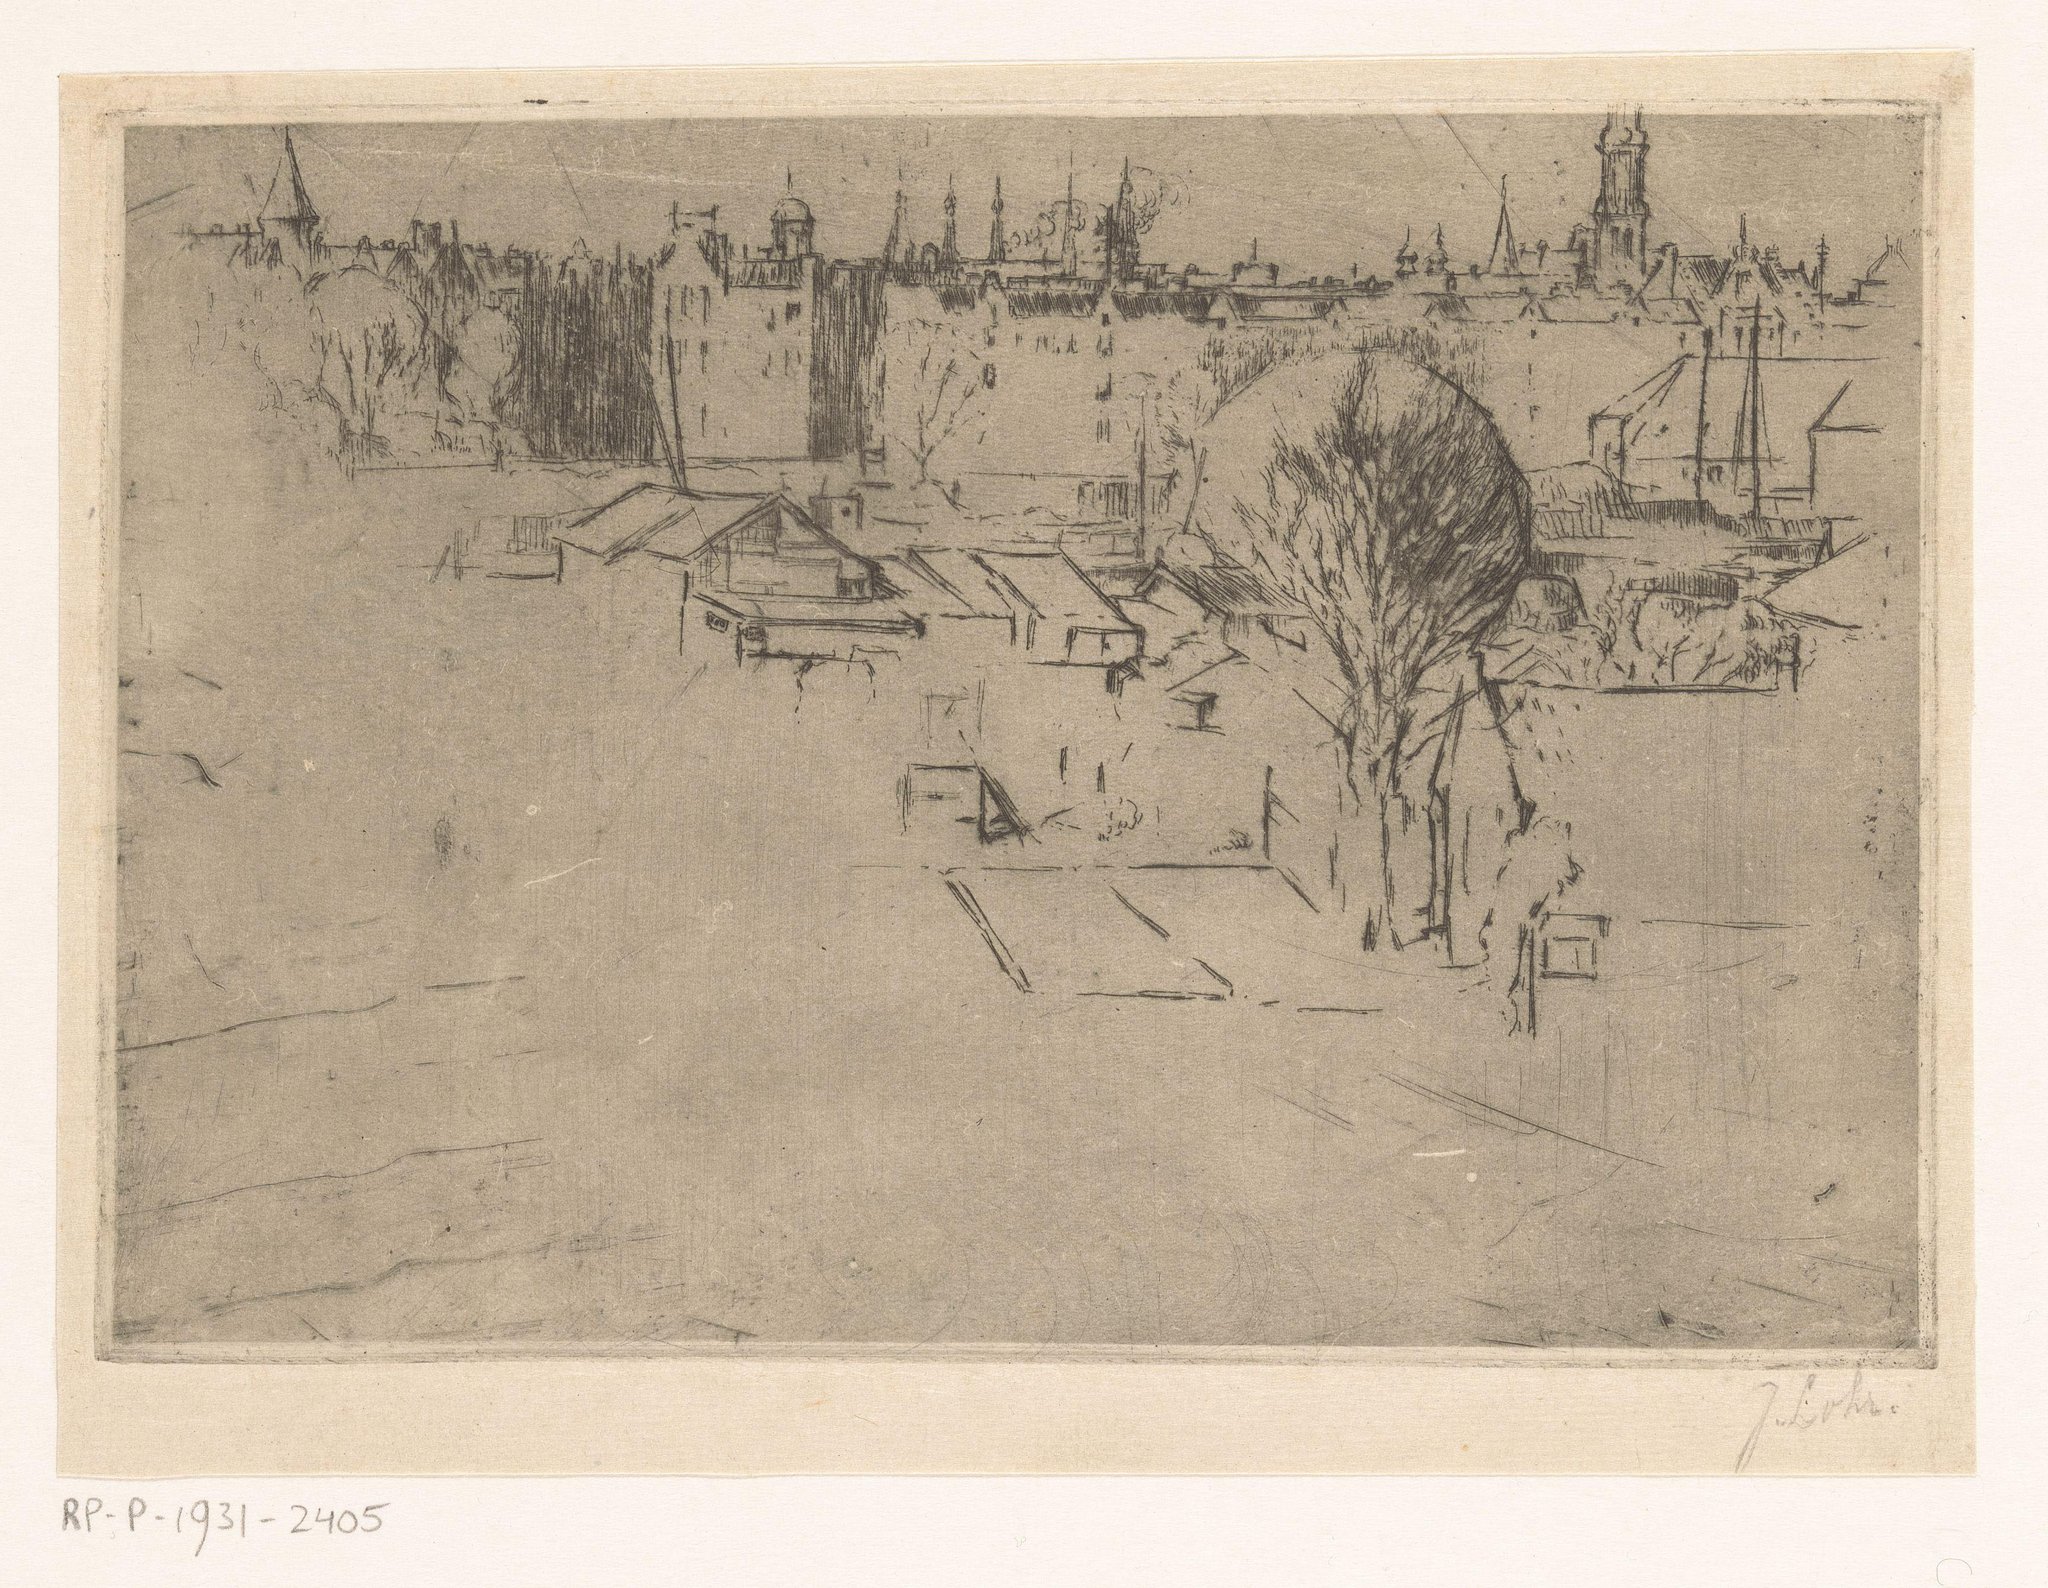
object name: print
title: Stadsrand van Amsterdam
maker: johannes löhr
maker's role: print maker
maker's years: 1882-1928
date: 1892-1928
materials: paper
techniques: etching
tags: city-view in general; 'veduta'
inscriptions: collector's mark: Lugt 2228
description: Rechts tussen de huizen een boom. Rechts op de achtergrond de Westertoren.